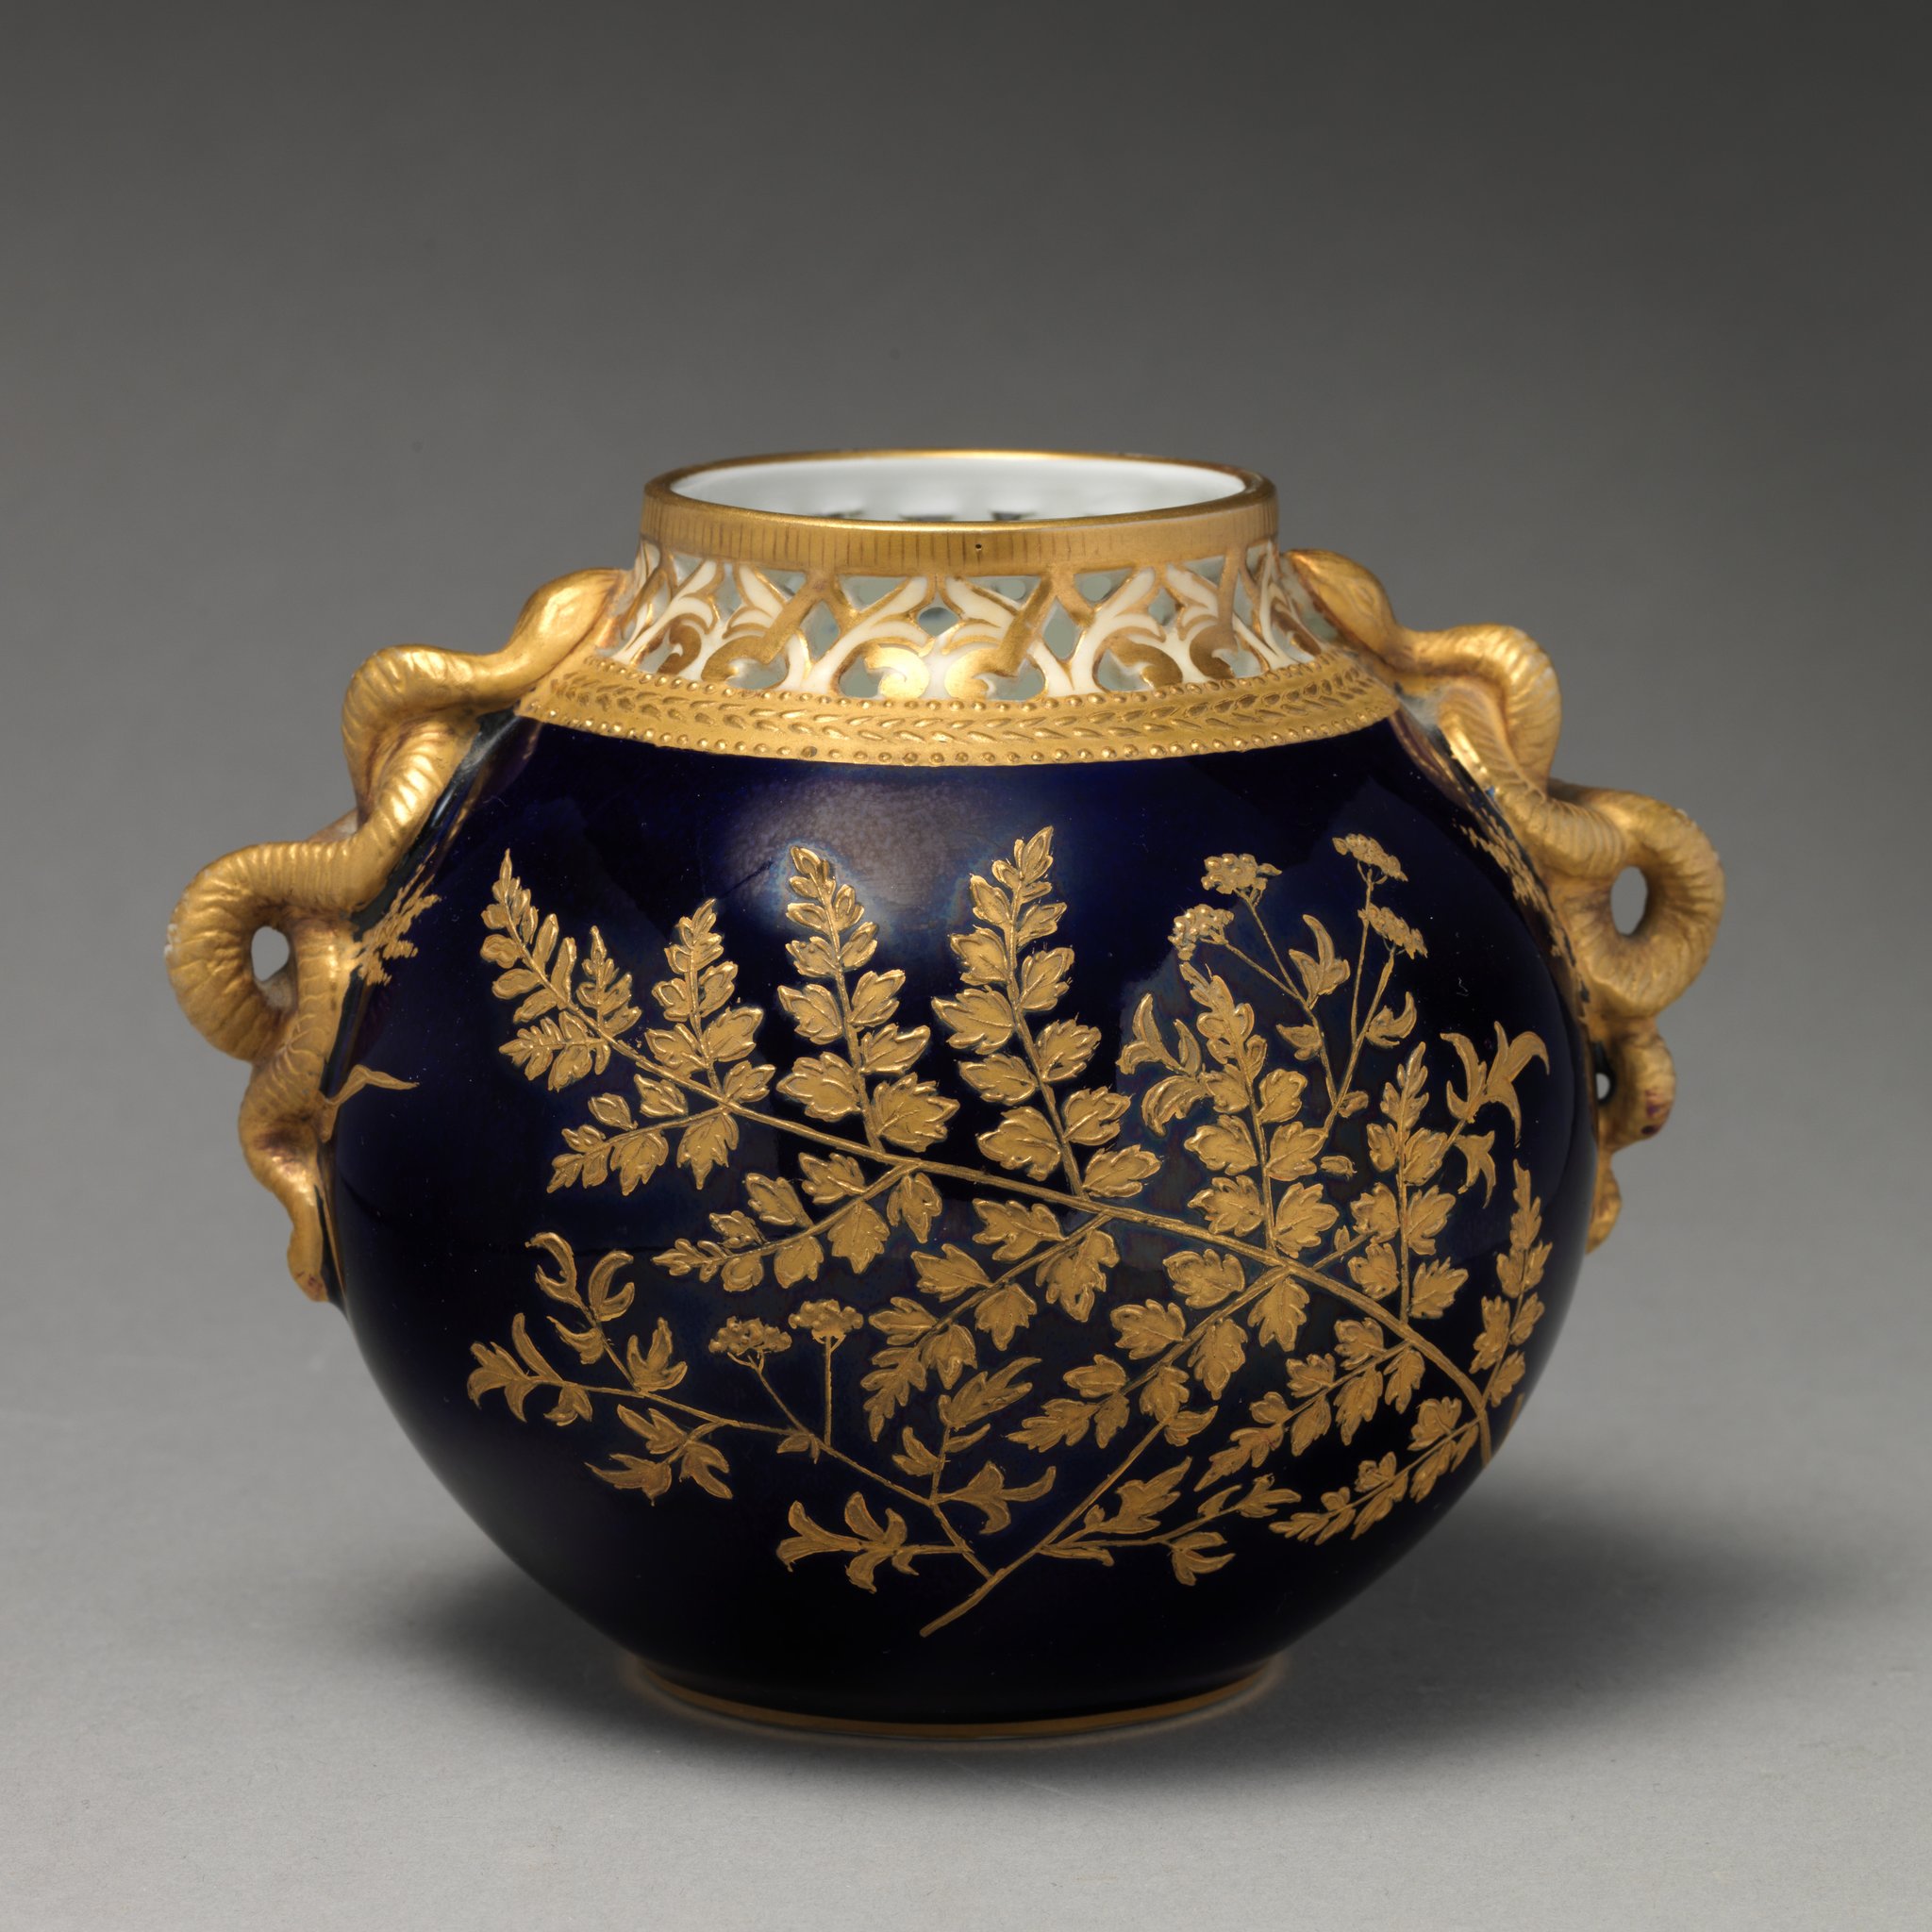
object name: vase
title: Orb vase with gold fern motif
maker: grainger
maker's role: maker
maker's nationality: british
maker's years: 1750-1850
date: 1870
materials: porcelain